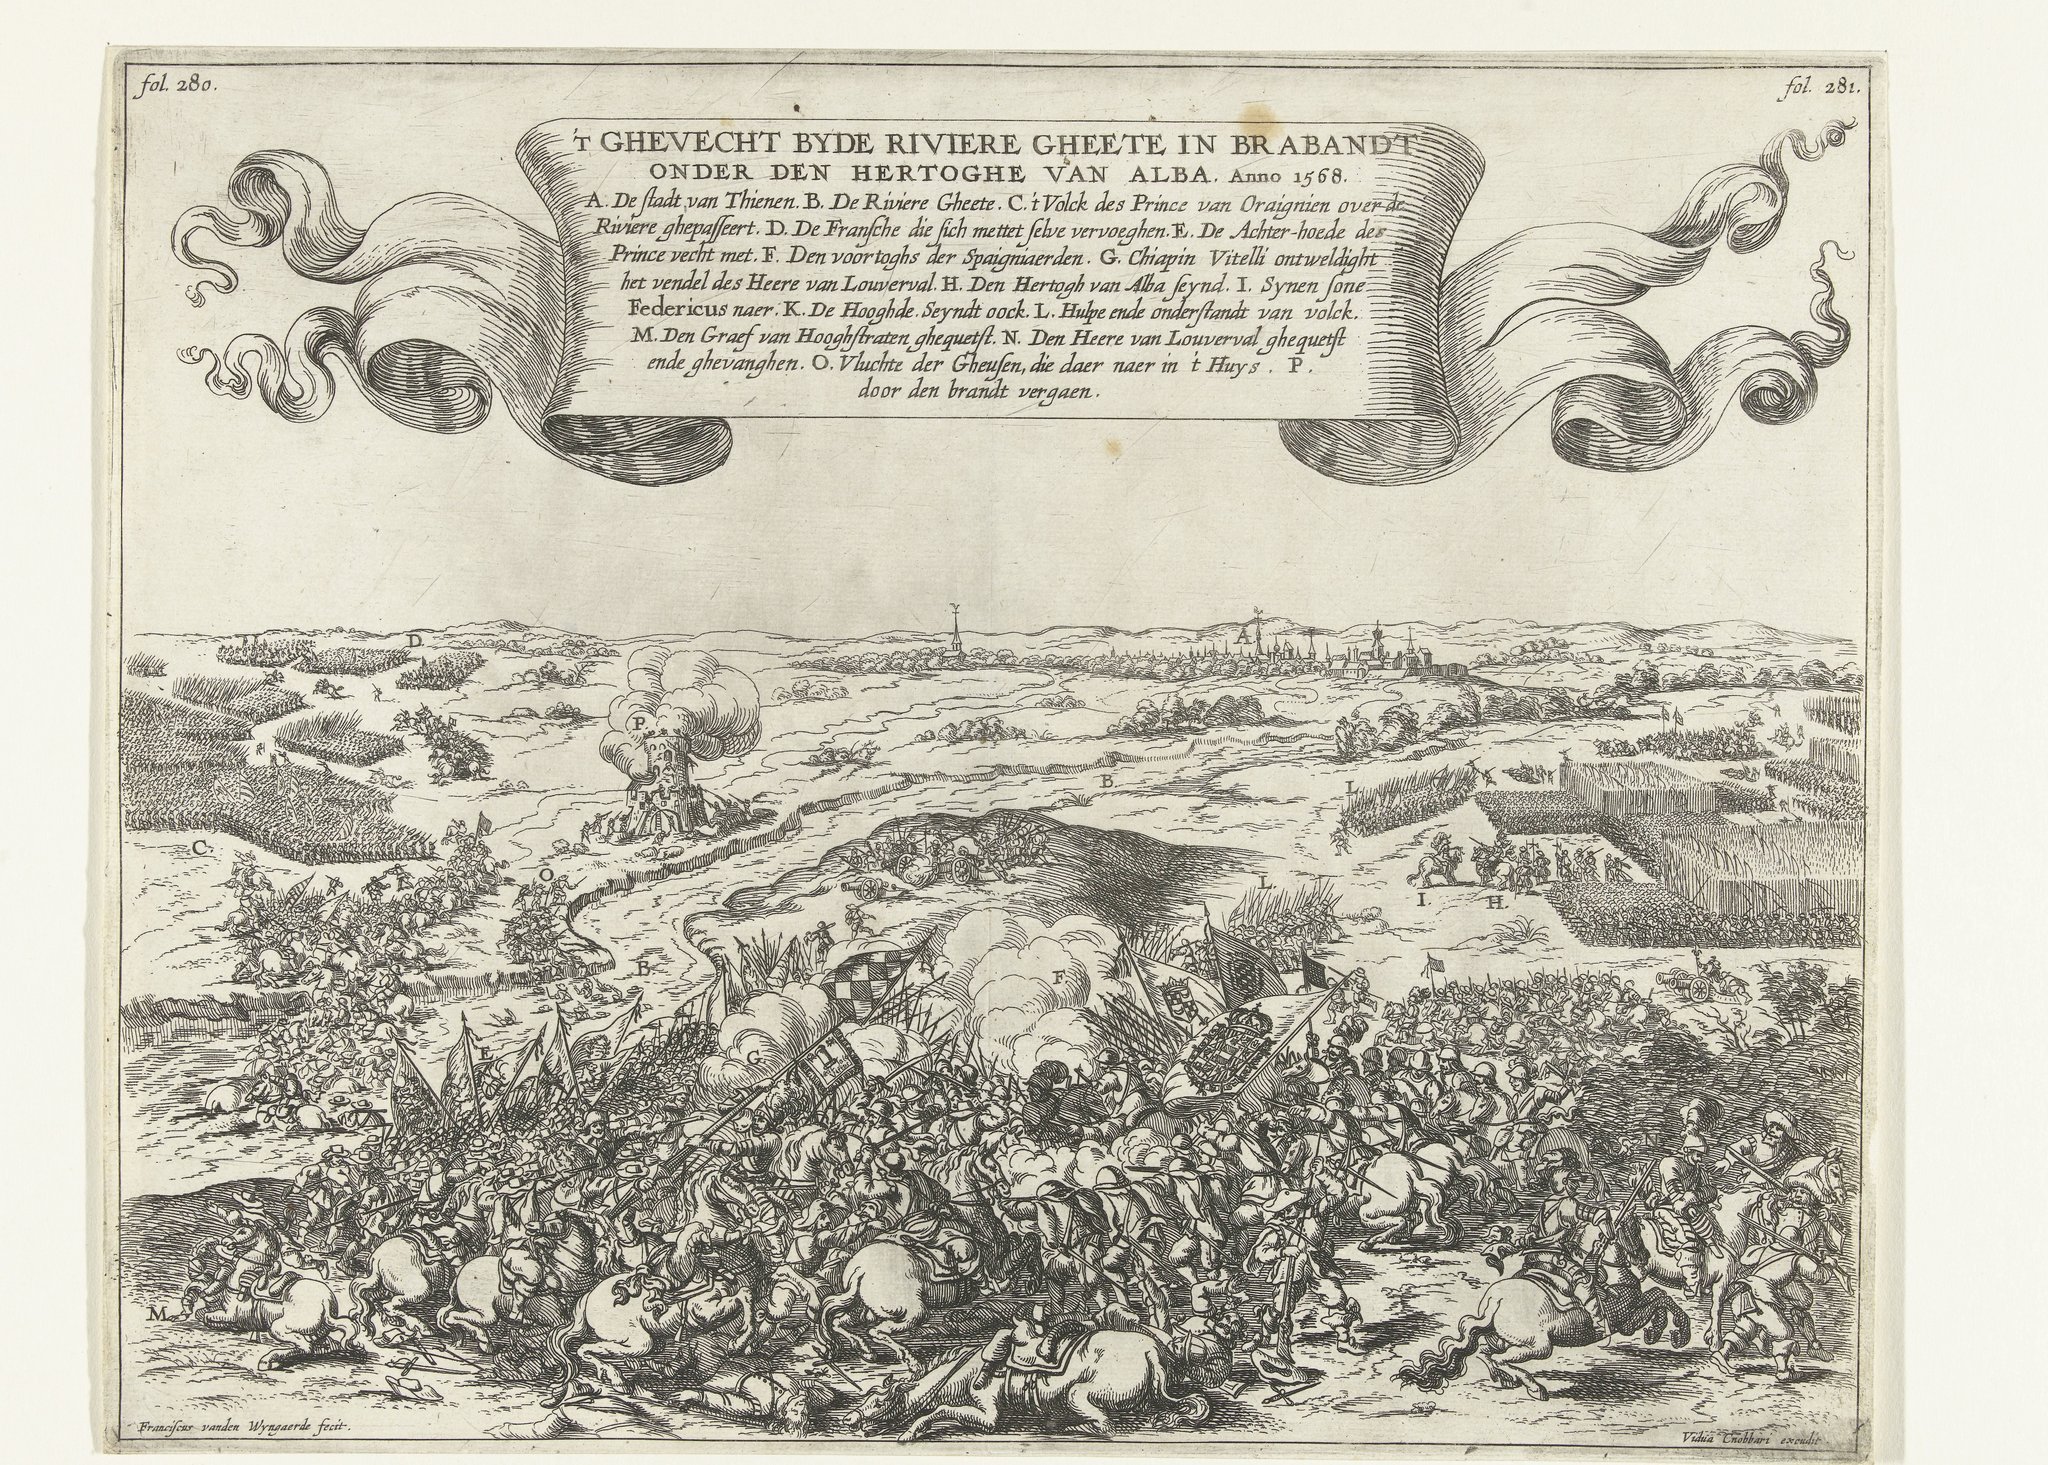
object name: print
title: Veldslag aan de rivier de Gete, 1568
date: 1643-1645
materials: paper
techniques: etching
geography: germany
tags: delft, william i (prince of orange), fernando álvarez de toledo (3rd duke of alba), battle (+ land forces)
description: Veldslag aan de rivier de Gete nabij Jodoigne en Tirlemont waarbij de achterhoede van het leger van de prins van Oranje verslagen wordt door Alva's leger, 19 oktober 1568. Op de voorgrond de veldslag, links vlucht het leger van Oranje door de rivier. Rechts de troepen van Alva opgesteld in slagorde. Bovenin een banderol met de titel en legenda A-P in het Nederlands.